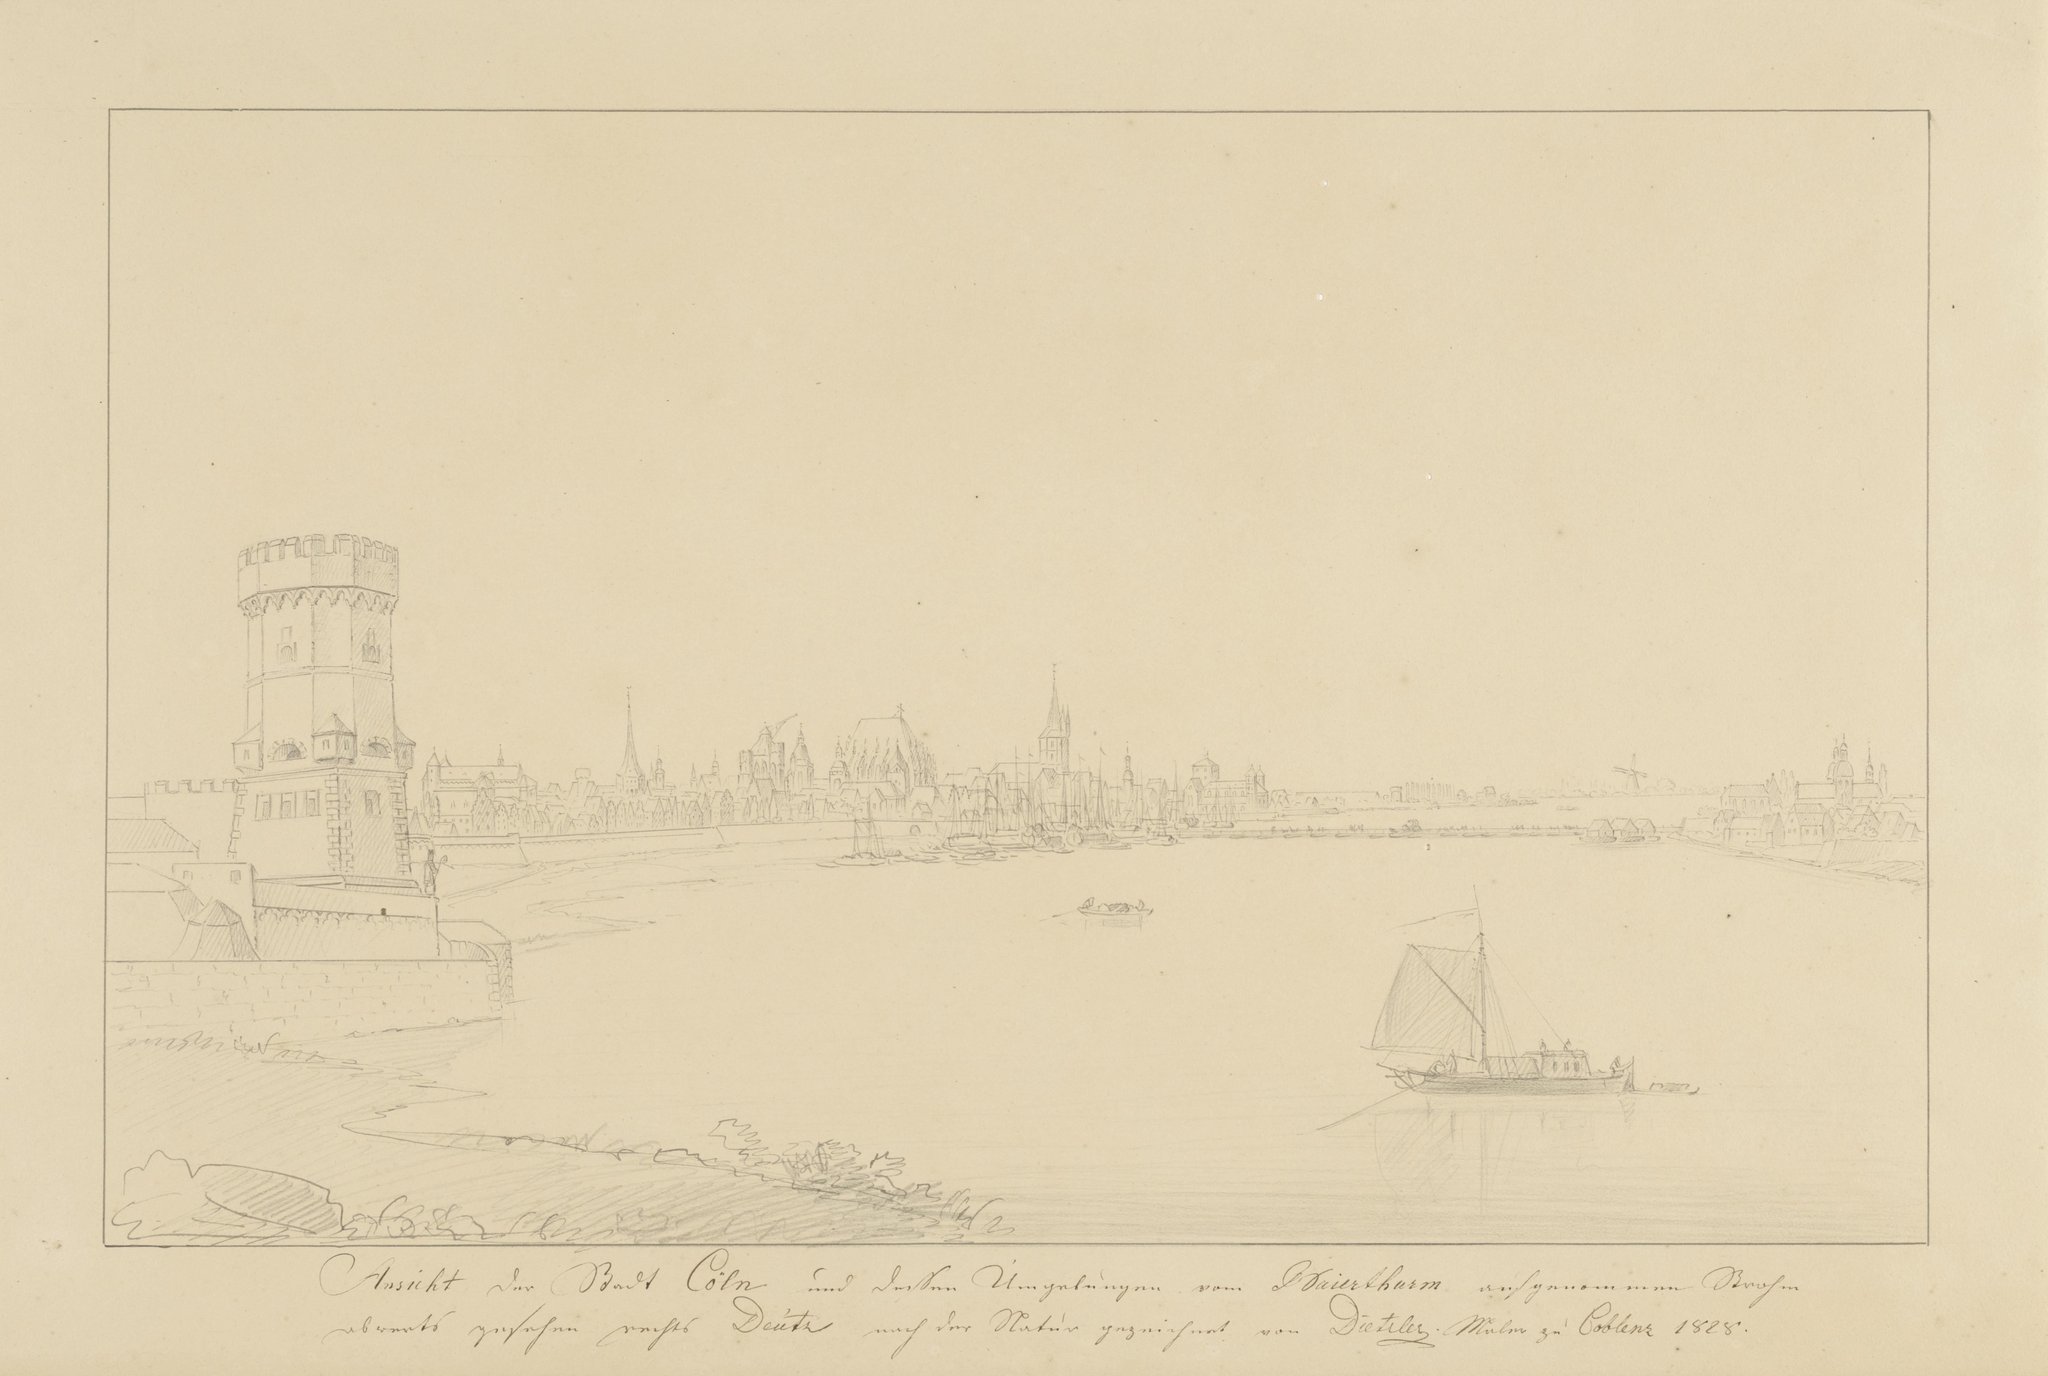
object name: drawing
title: Gezicht op Köln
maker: jakob dietzler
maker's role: draughtsman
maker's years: 1789-1855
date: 1828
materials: ink, paper, pencil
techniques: pen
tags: river (+ landscape with figures, staffage), prospect of city, town panorama, silhouette of city (+ city(-scape) with figures, staffage), cologne